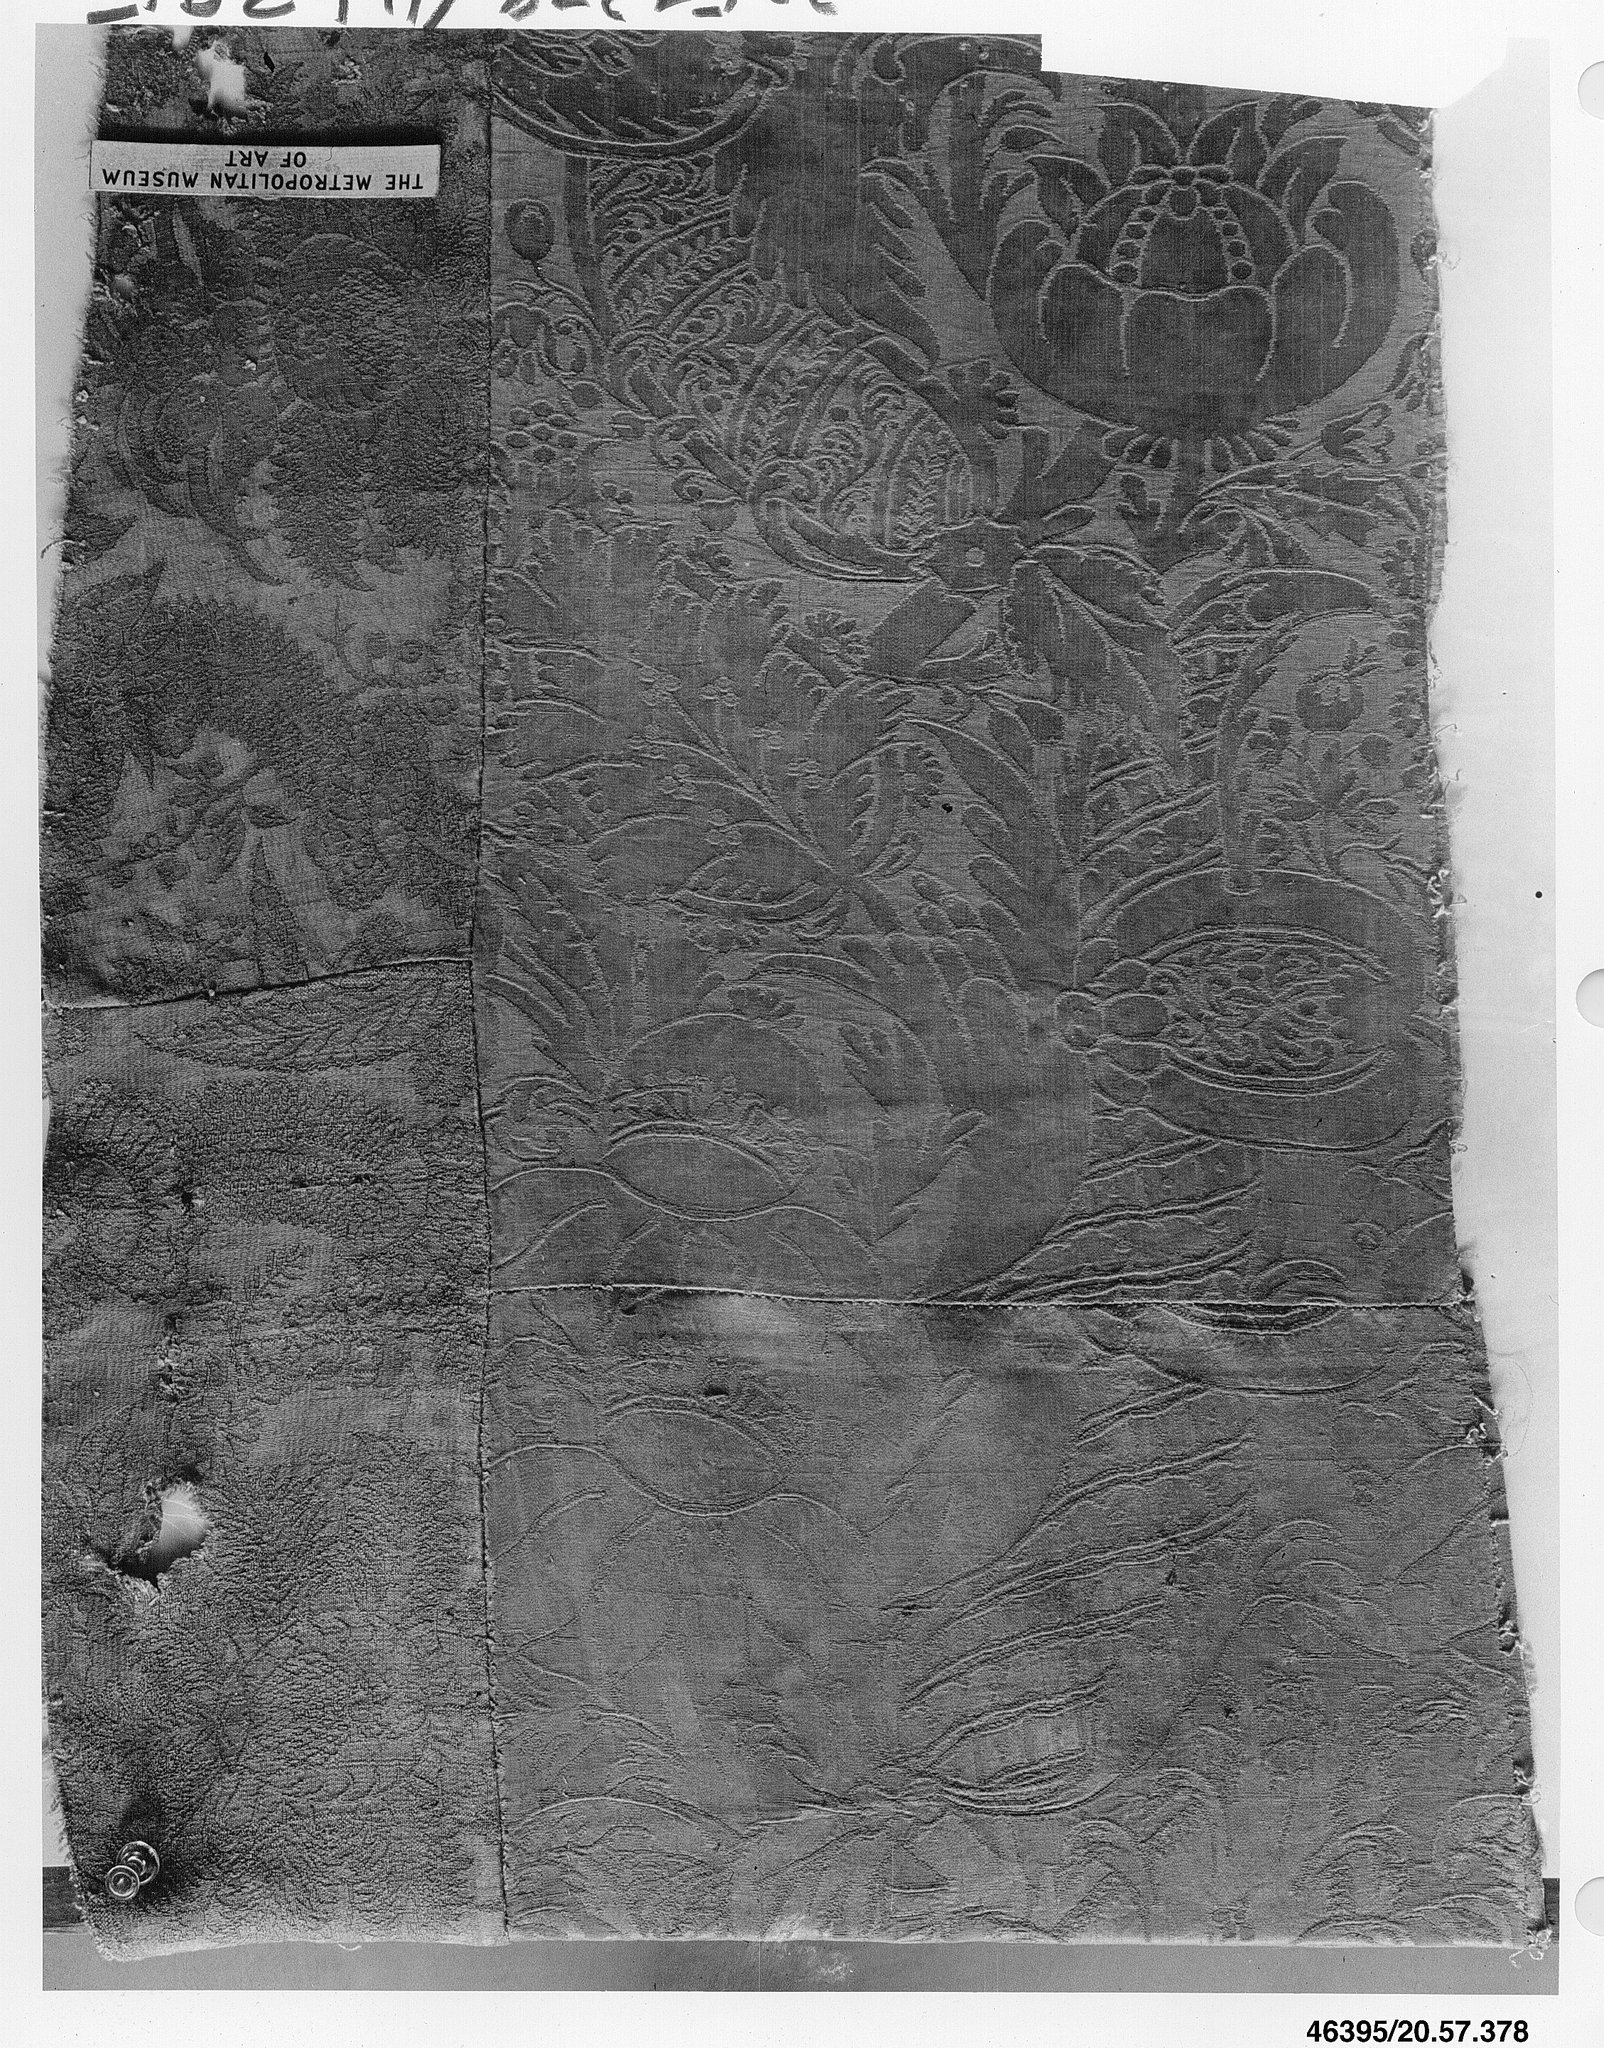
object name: piece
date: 1601-1700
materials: silk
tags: flowers,leaves